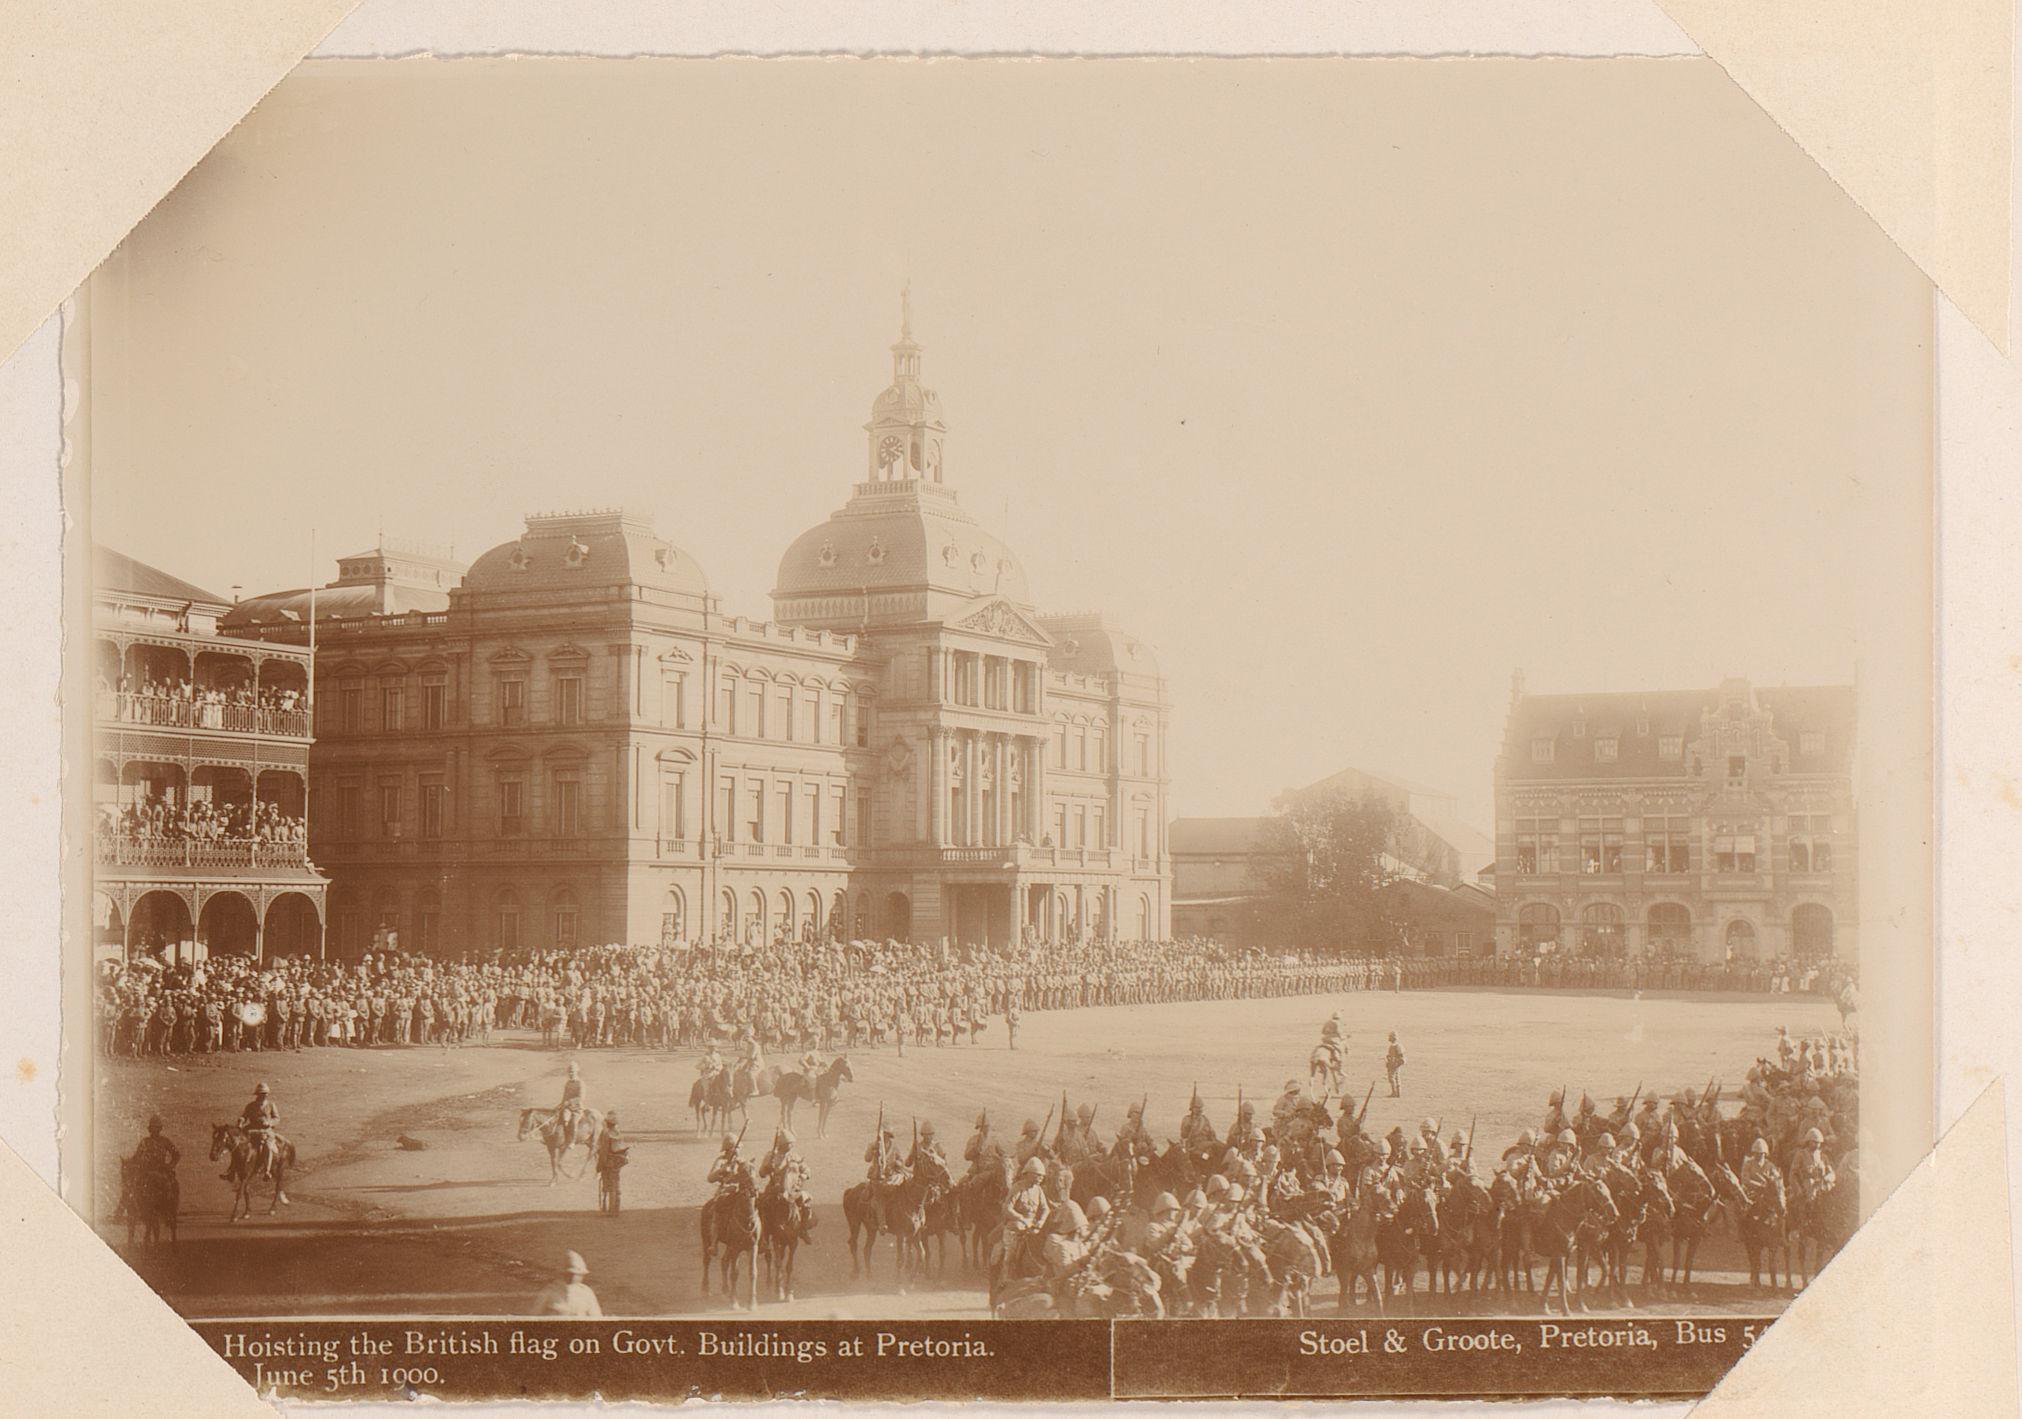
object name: photograph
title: Hijsen van de Britse vlag op overheidsgebouw in Pretoria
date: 1900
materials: paper, photographic support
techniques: gelatin silver print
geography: pretoria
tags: flag raising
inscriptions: negative number: ‘no. 710 Pretoria, Bus 545’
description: Onderdeel van Album met 191 foto's van een reis naar en door Zuid-Afrika.